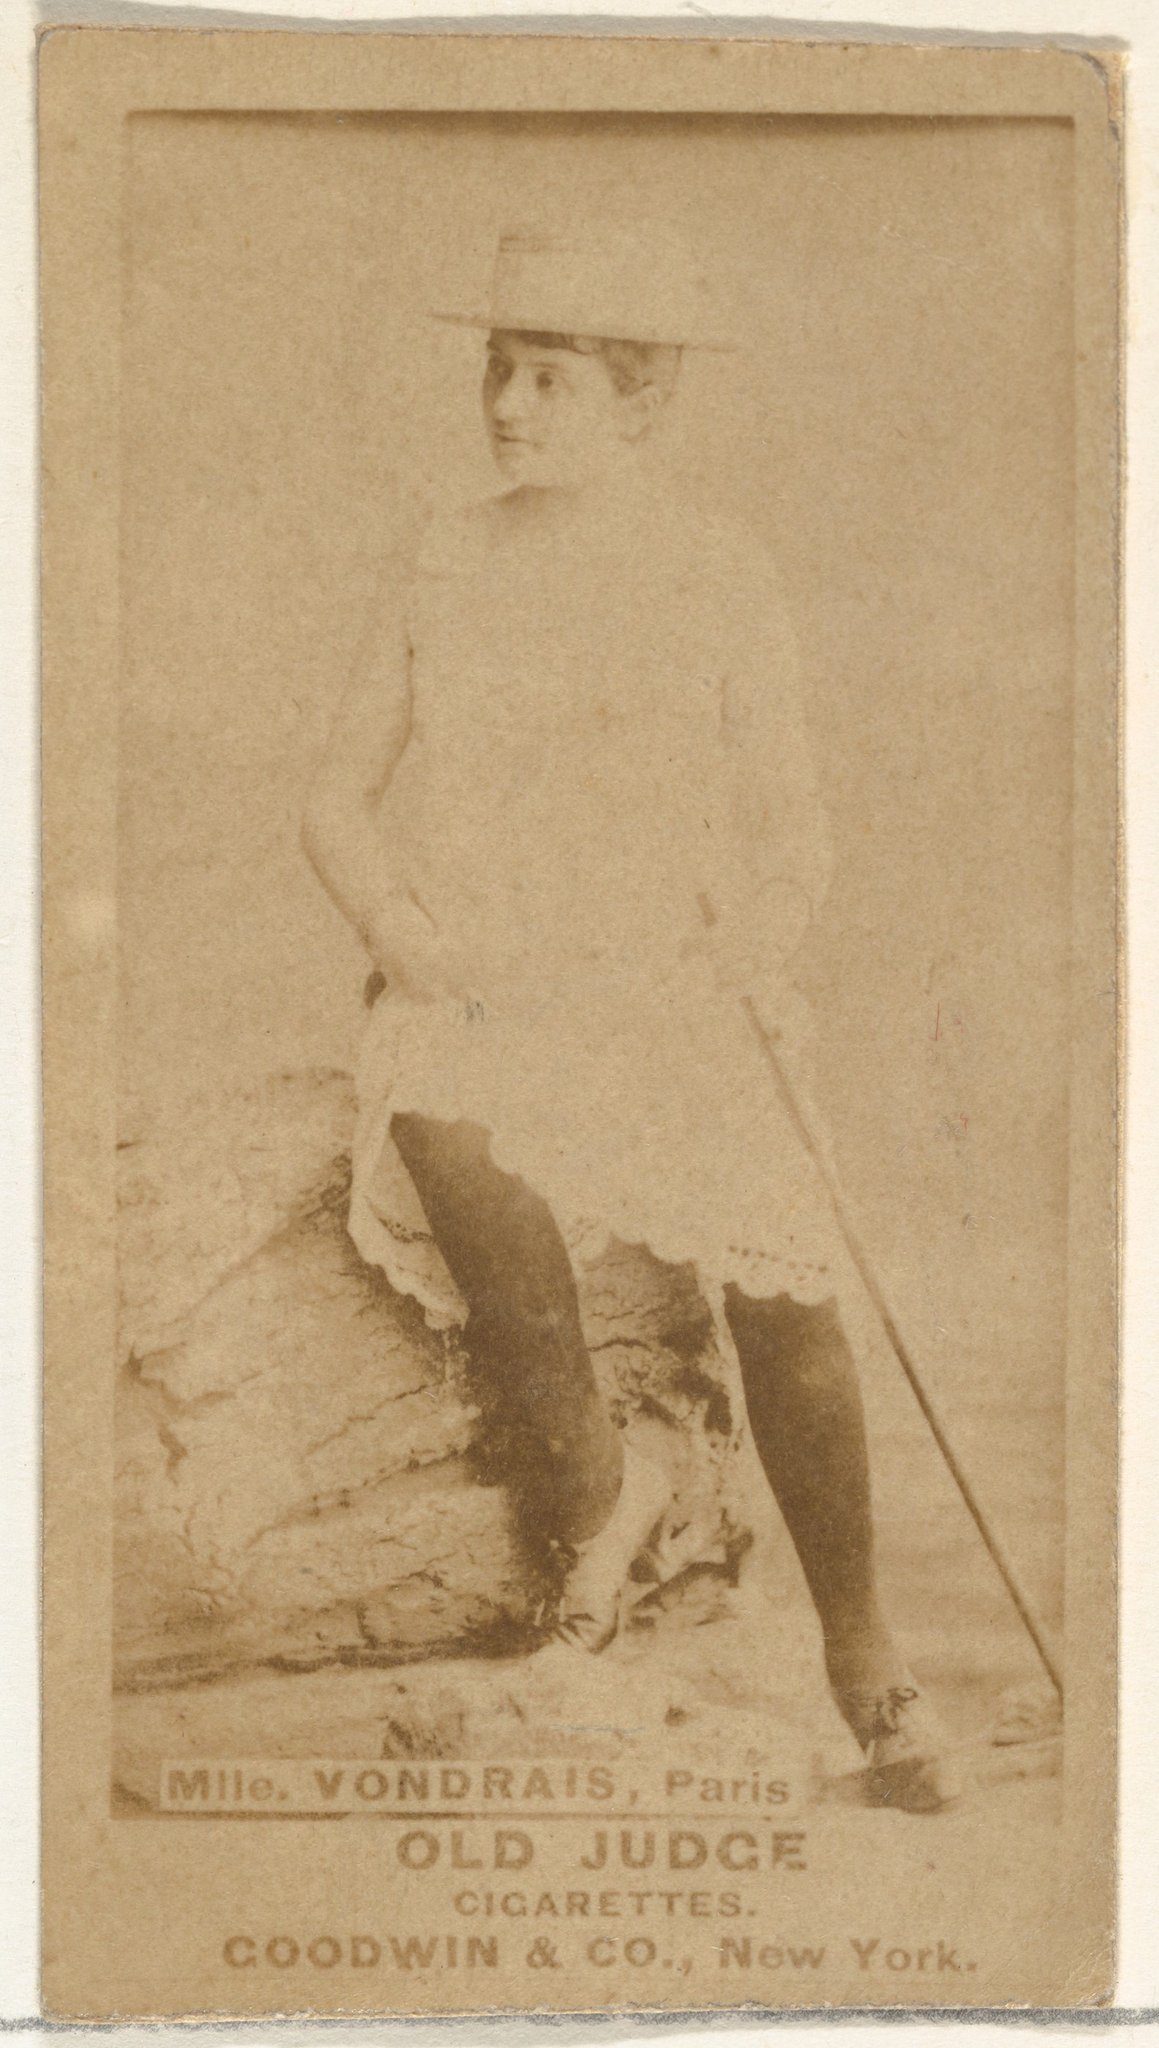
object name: photograph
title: Mlle. Vondrais, Paris, from the Actors and Actresses series (N171) for Old Judge Cigarettes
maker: goodwin & company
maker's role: publisher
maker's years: 1850-1950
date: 1886-1890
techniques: albumen silver print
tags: portraits,women,actresses